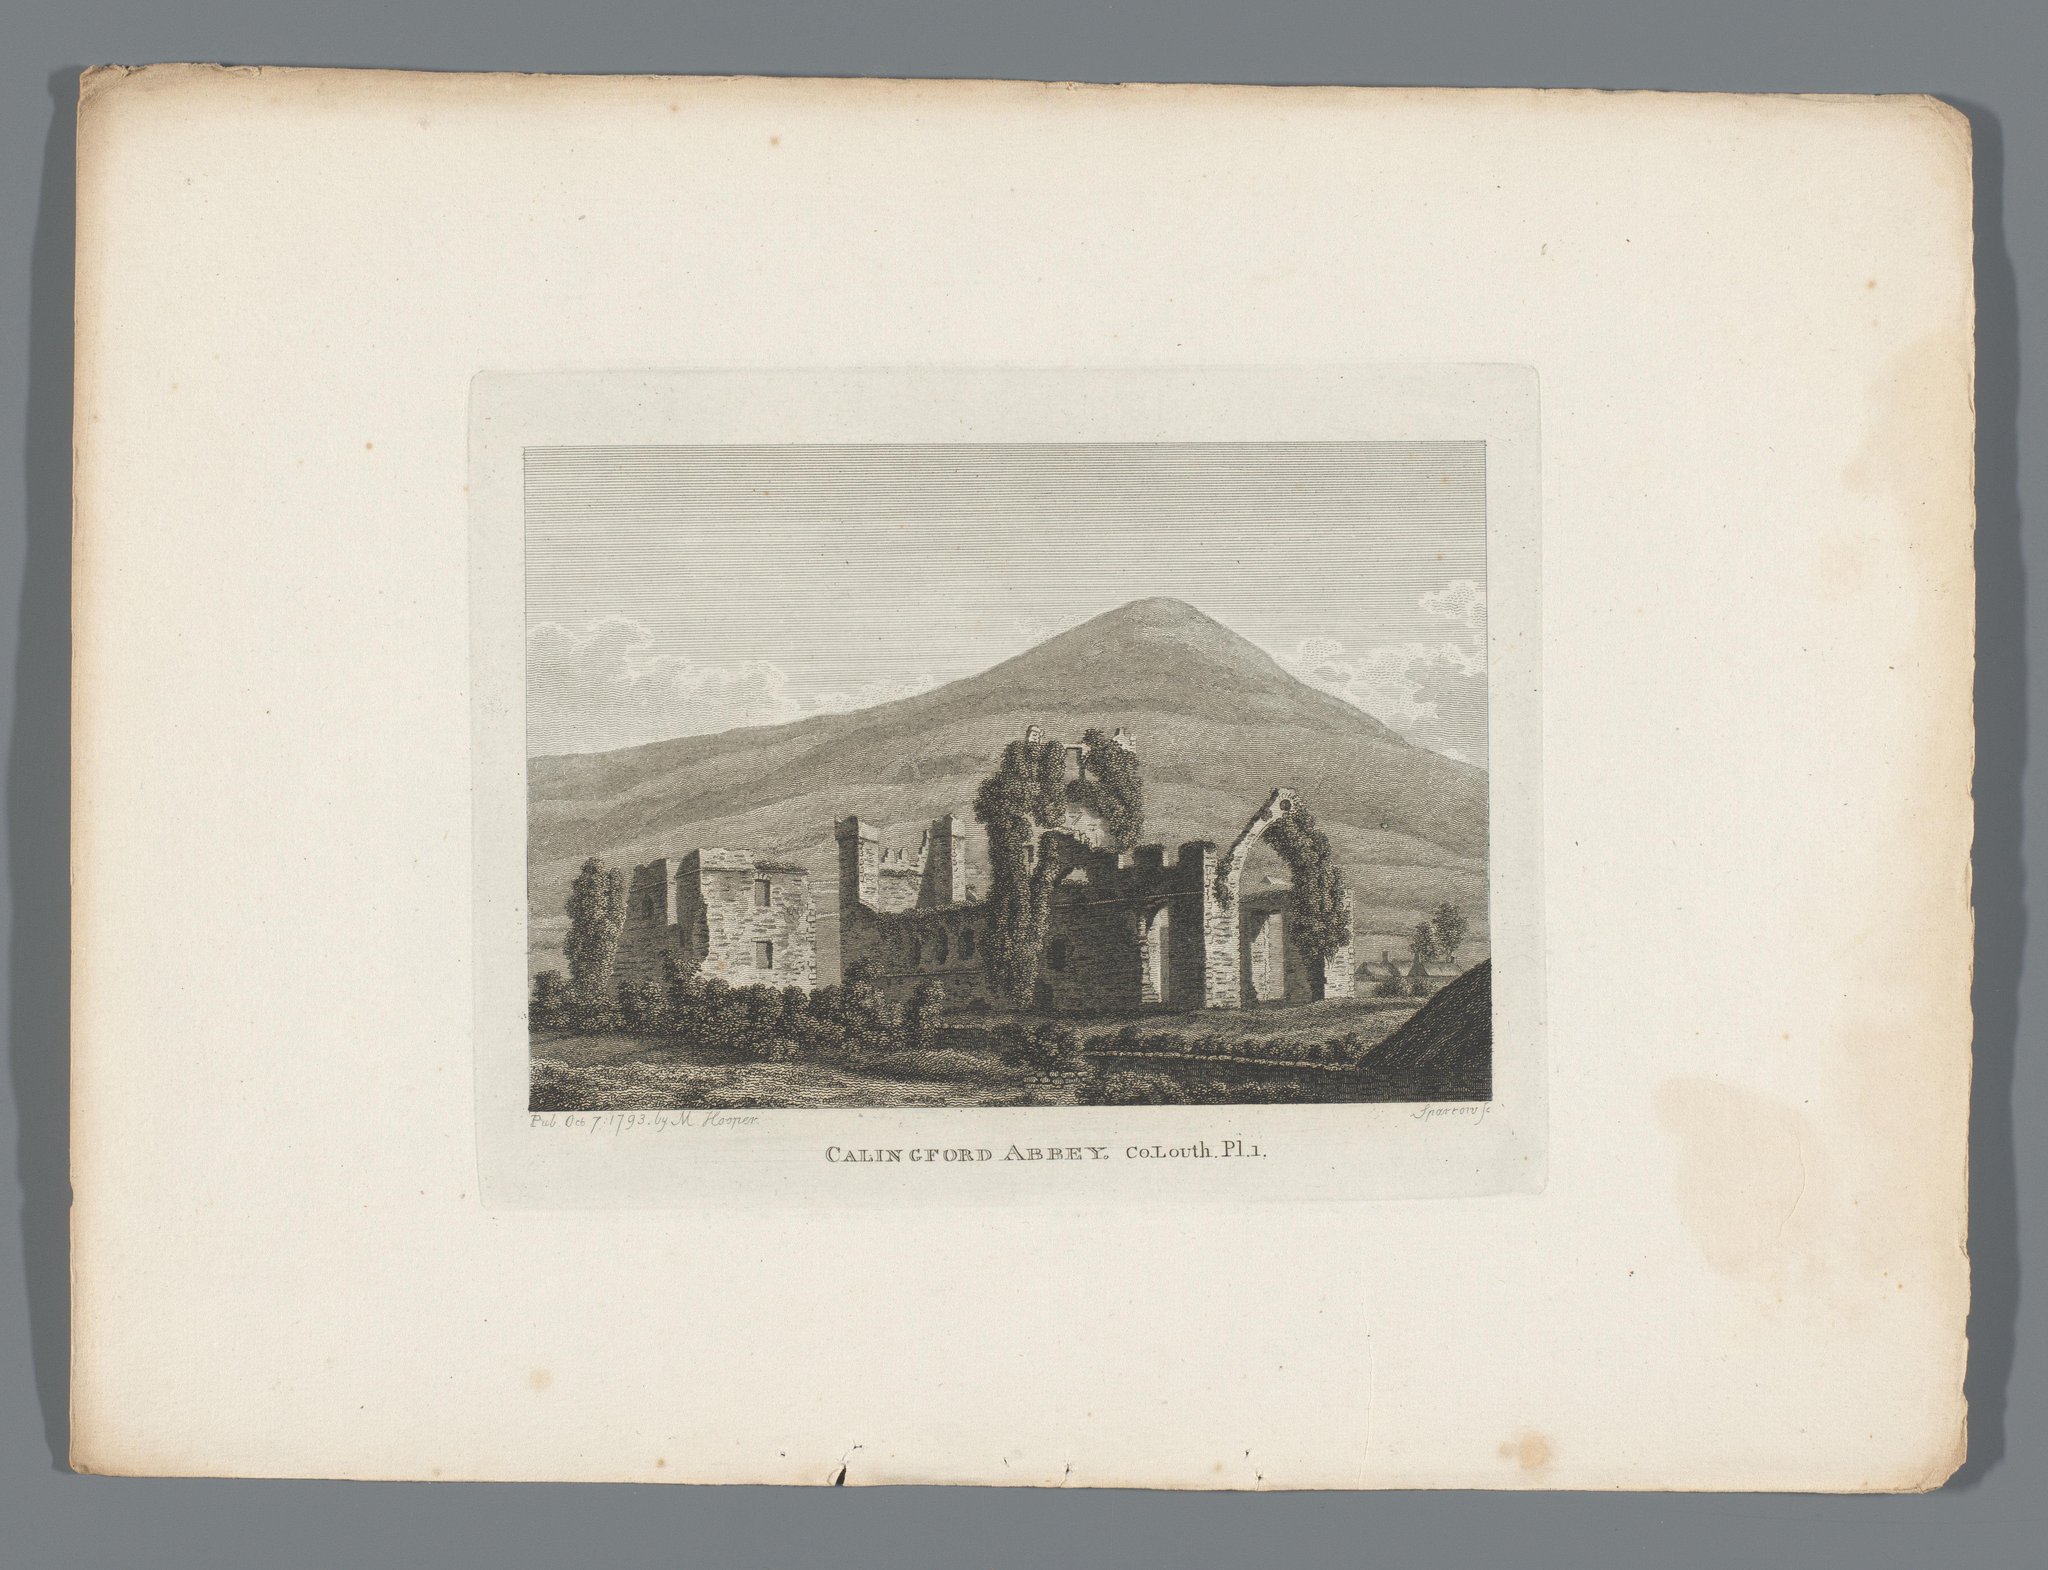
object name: print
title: Gezicht op de ruïnes van de abdij van Carlingford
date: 1793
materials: paper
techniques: etching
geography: london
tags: city-view, and landscape with man-made constructions, abbey, monastery, convent ~ roman catholic church, landscape with ruins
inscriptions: date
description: Prent verschenen in: Grose, Francis. The antiquities of Ireland, dl. 2. Londen: S. Hooper, 1795.